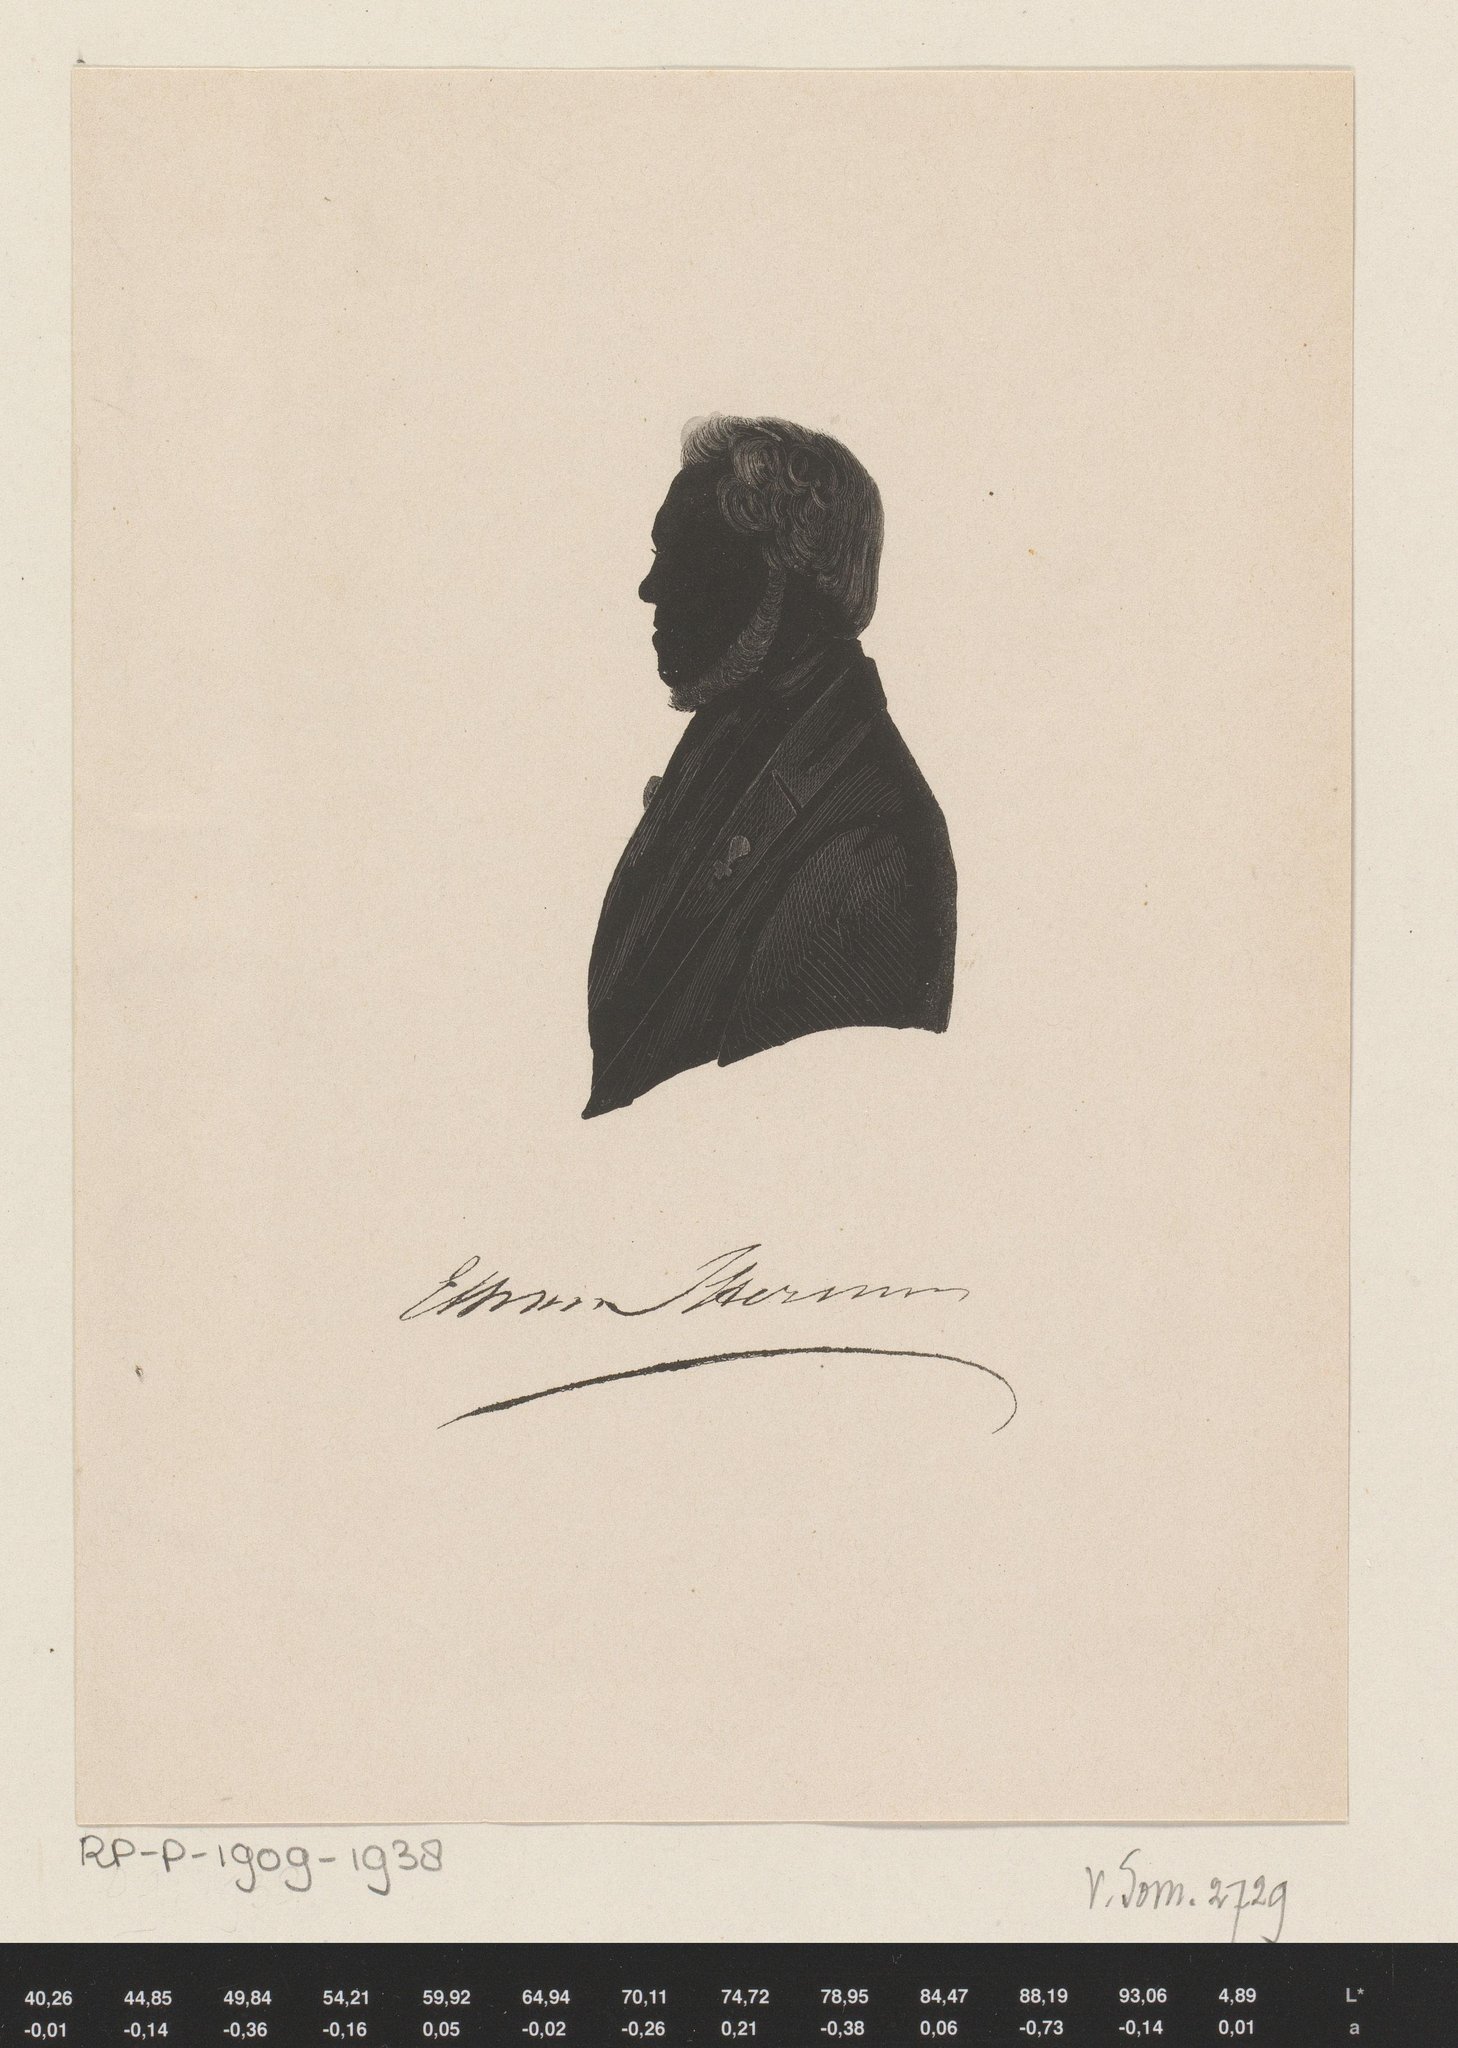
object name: print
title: Silhouetportret van Ernst Hendrik van Ittersum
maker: Anonymous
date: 1709-1740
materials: paper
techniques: engraving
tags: historical persons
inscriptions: collector's mark: Lugt 2228